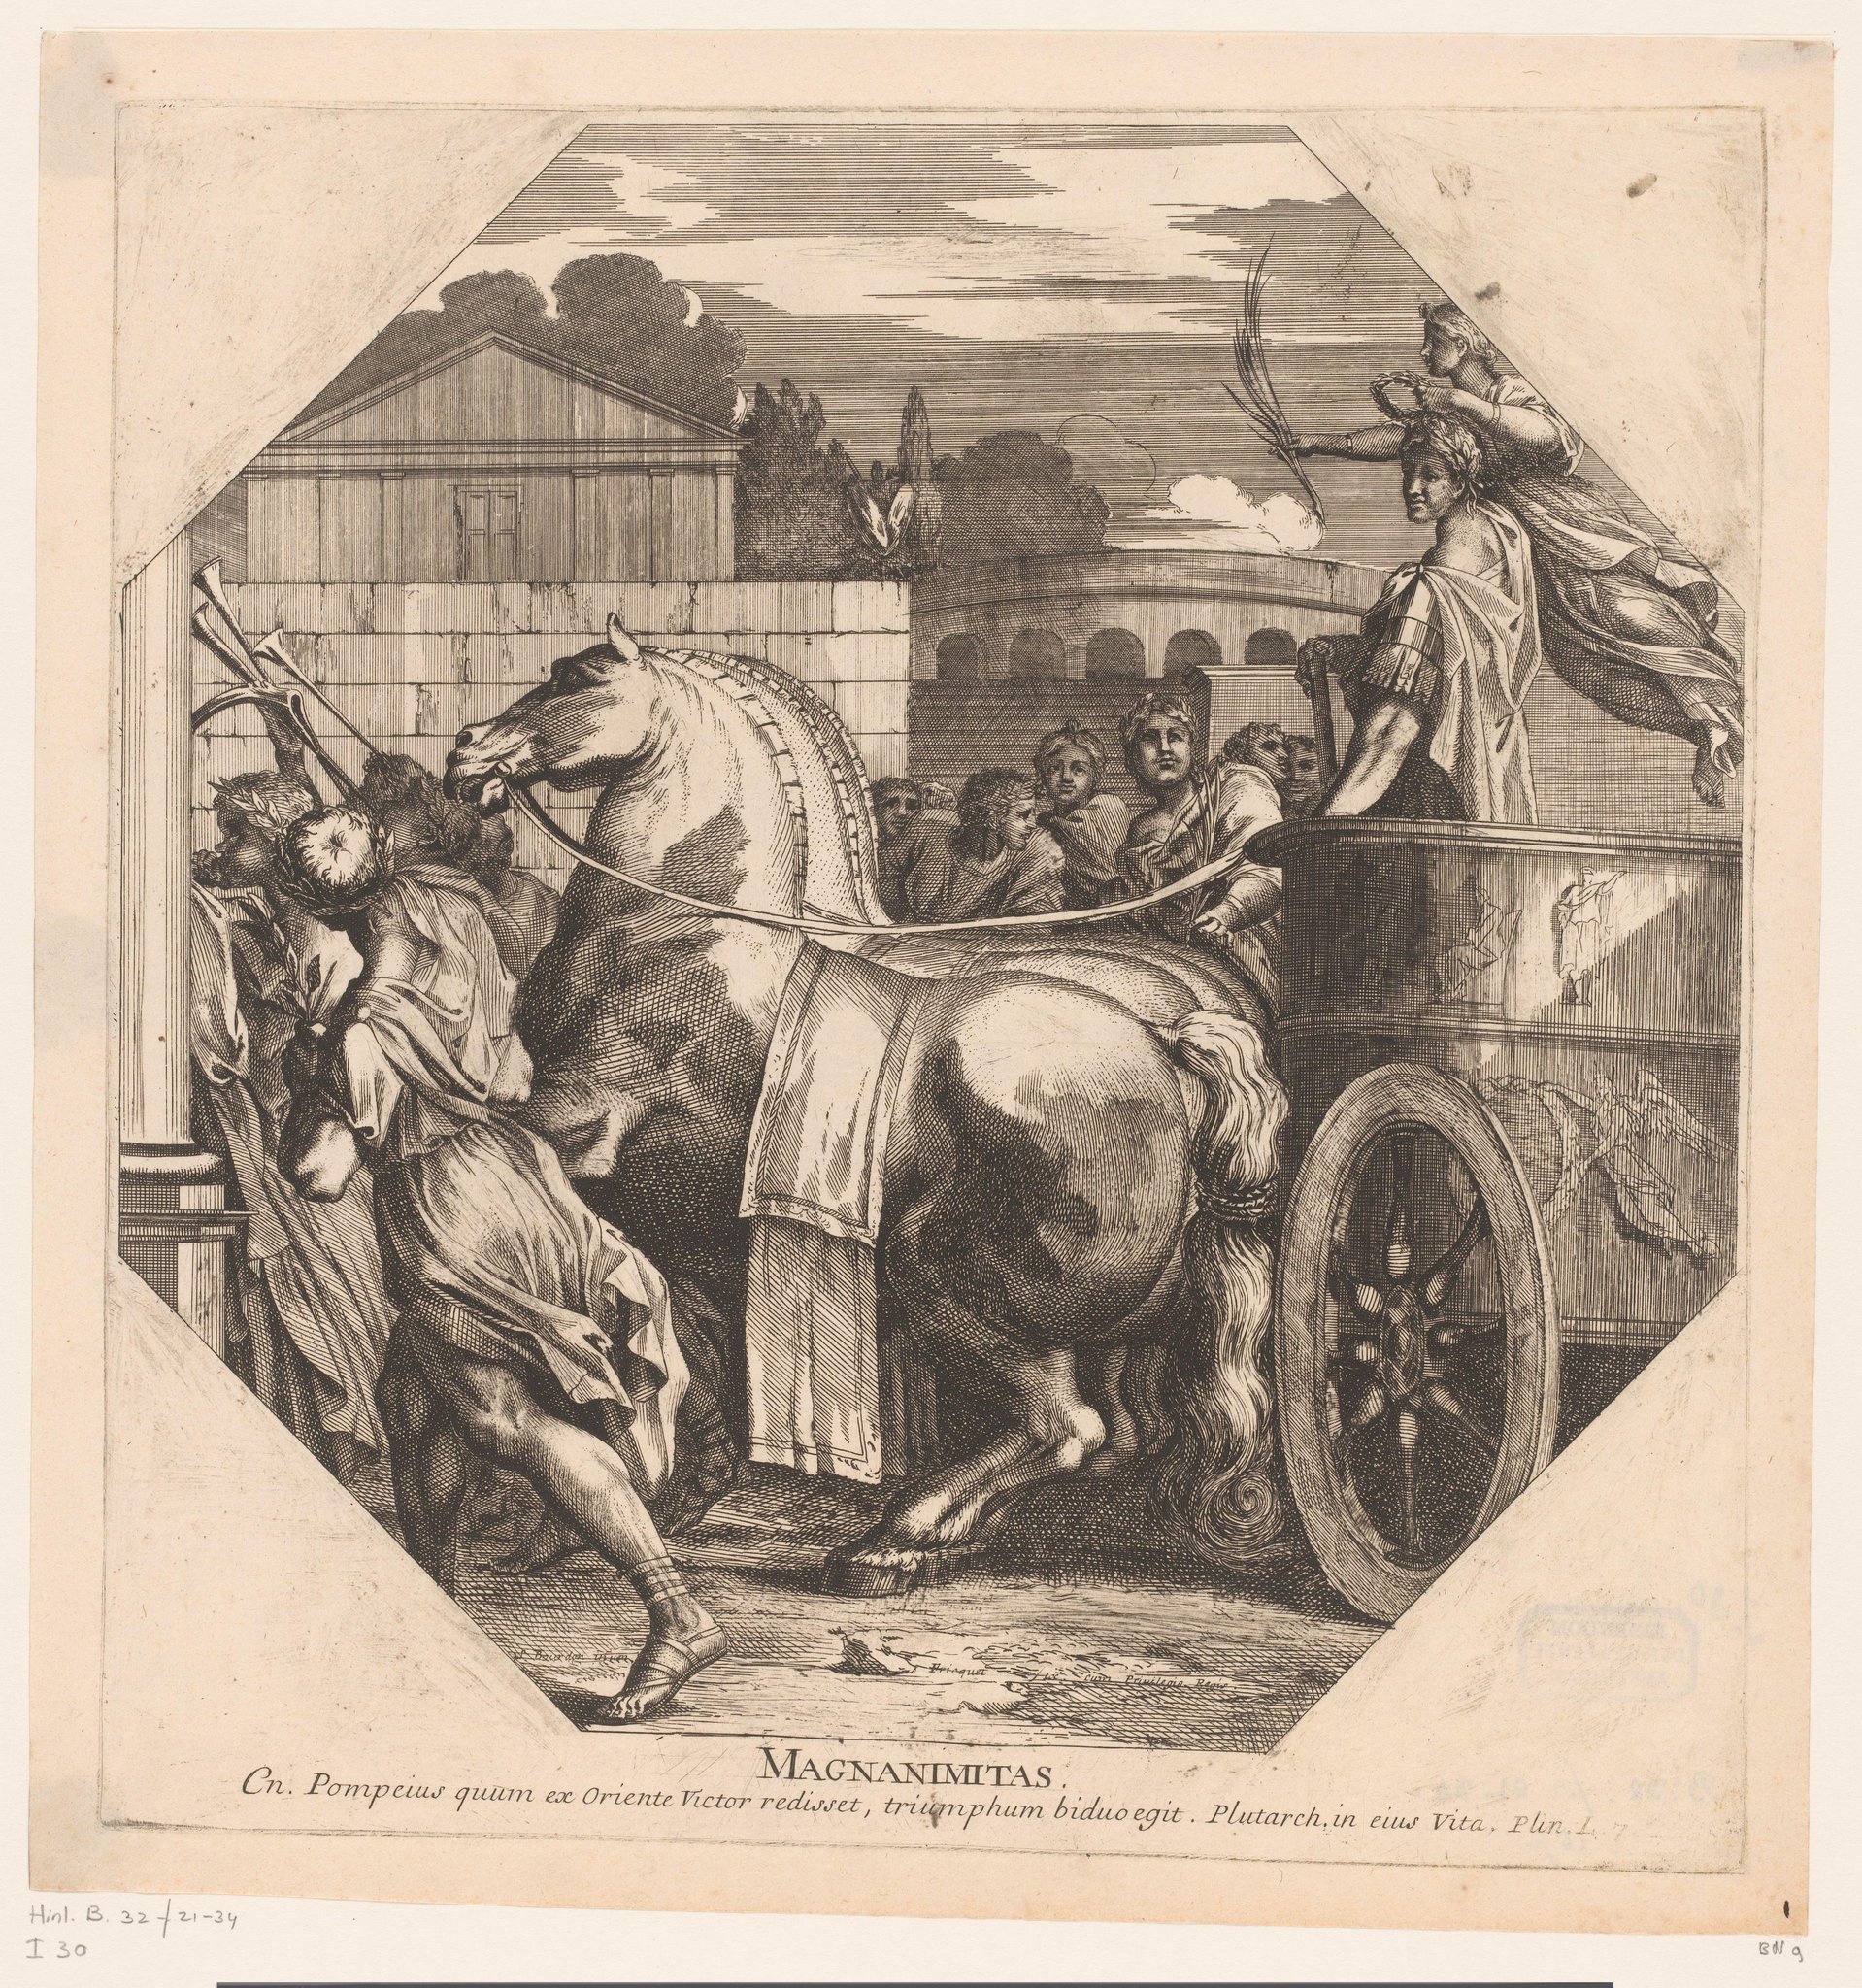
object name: print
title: Vrije kunsten en deugden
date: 1663-1716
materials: paper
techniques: engraving, etching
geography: france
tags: rome, politician, historical persons, magnanimity; 'grandezza e robustezza d'animo', 'magnanimità' (ripa)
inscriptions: number: ‘1’, collector's mark: Lugt 11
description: Maakt deel uit van een veertiendelige serie opgedeeld in twee reeksen, met als onderwerp de zeven vrije kunsten en deugden naar schilderijen door Sébastien Bourdon. De schilderijen werden in 1663 vervaardigd voor de Grande Galerie van het Hôtel de Bretonvilliers te Parijs.